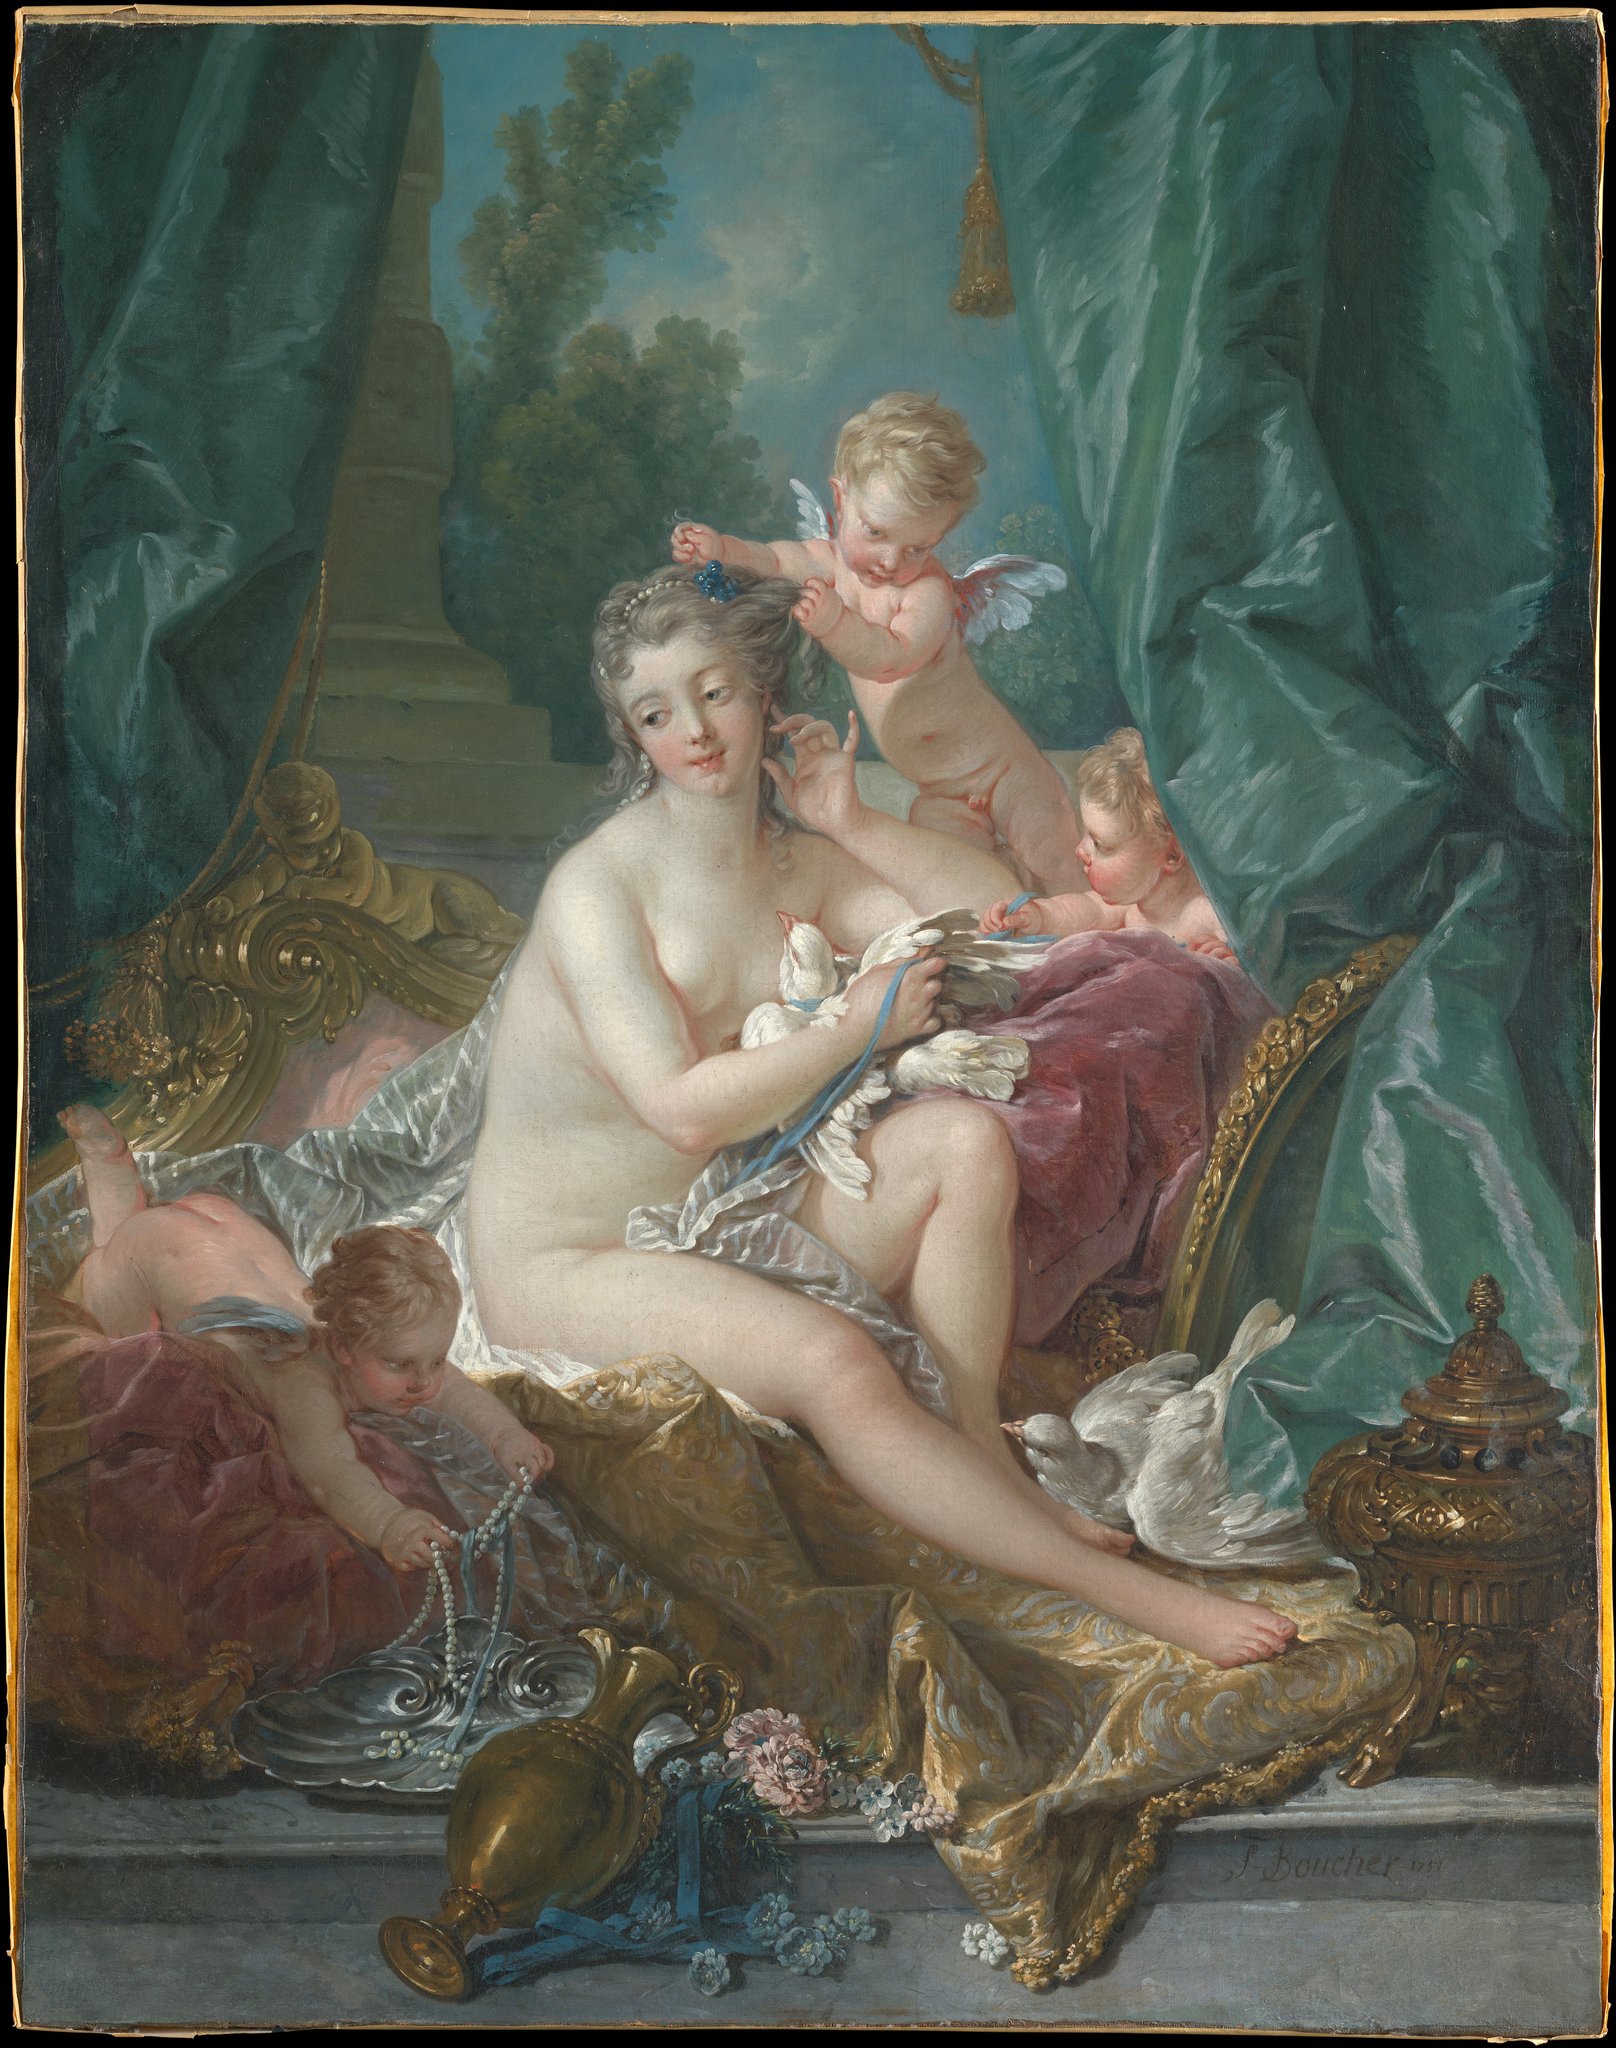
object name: painting, overdoor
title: The Toilette of Venus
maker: françois boucher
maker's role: artist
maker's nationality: french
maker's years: 1703-1770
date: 1751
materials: canvas, oil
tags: female nudes,venus